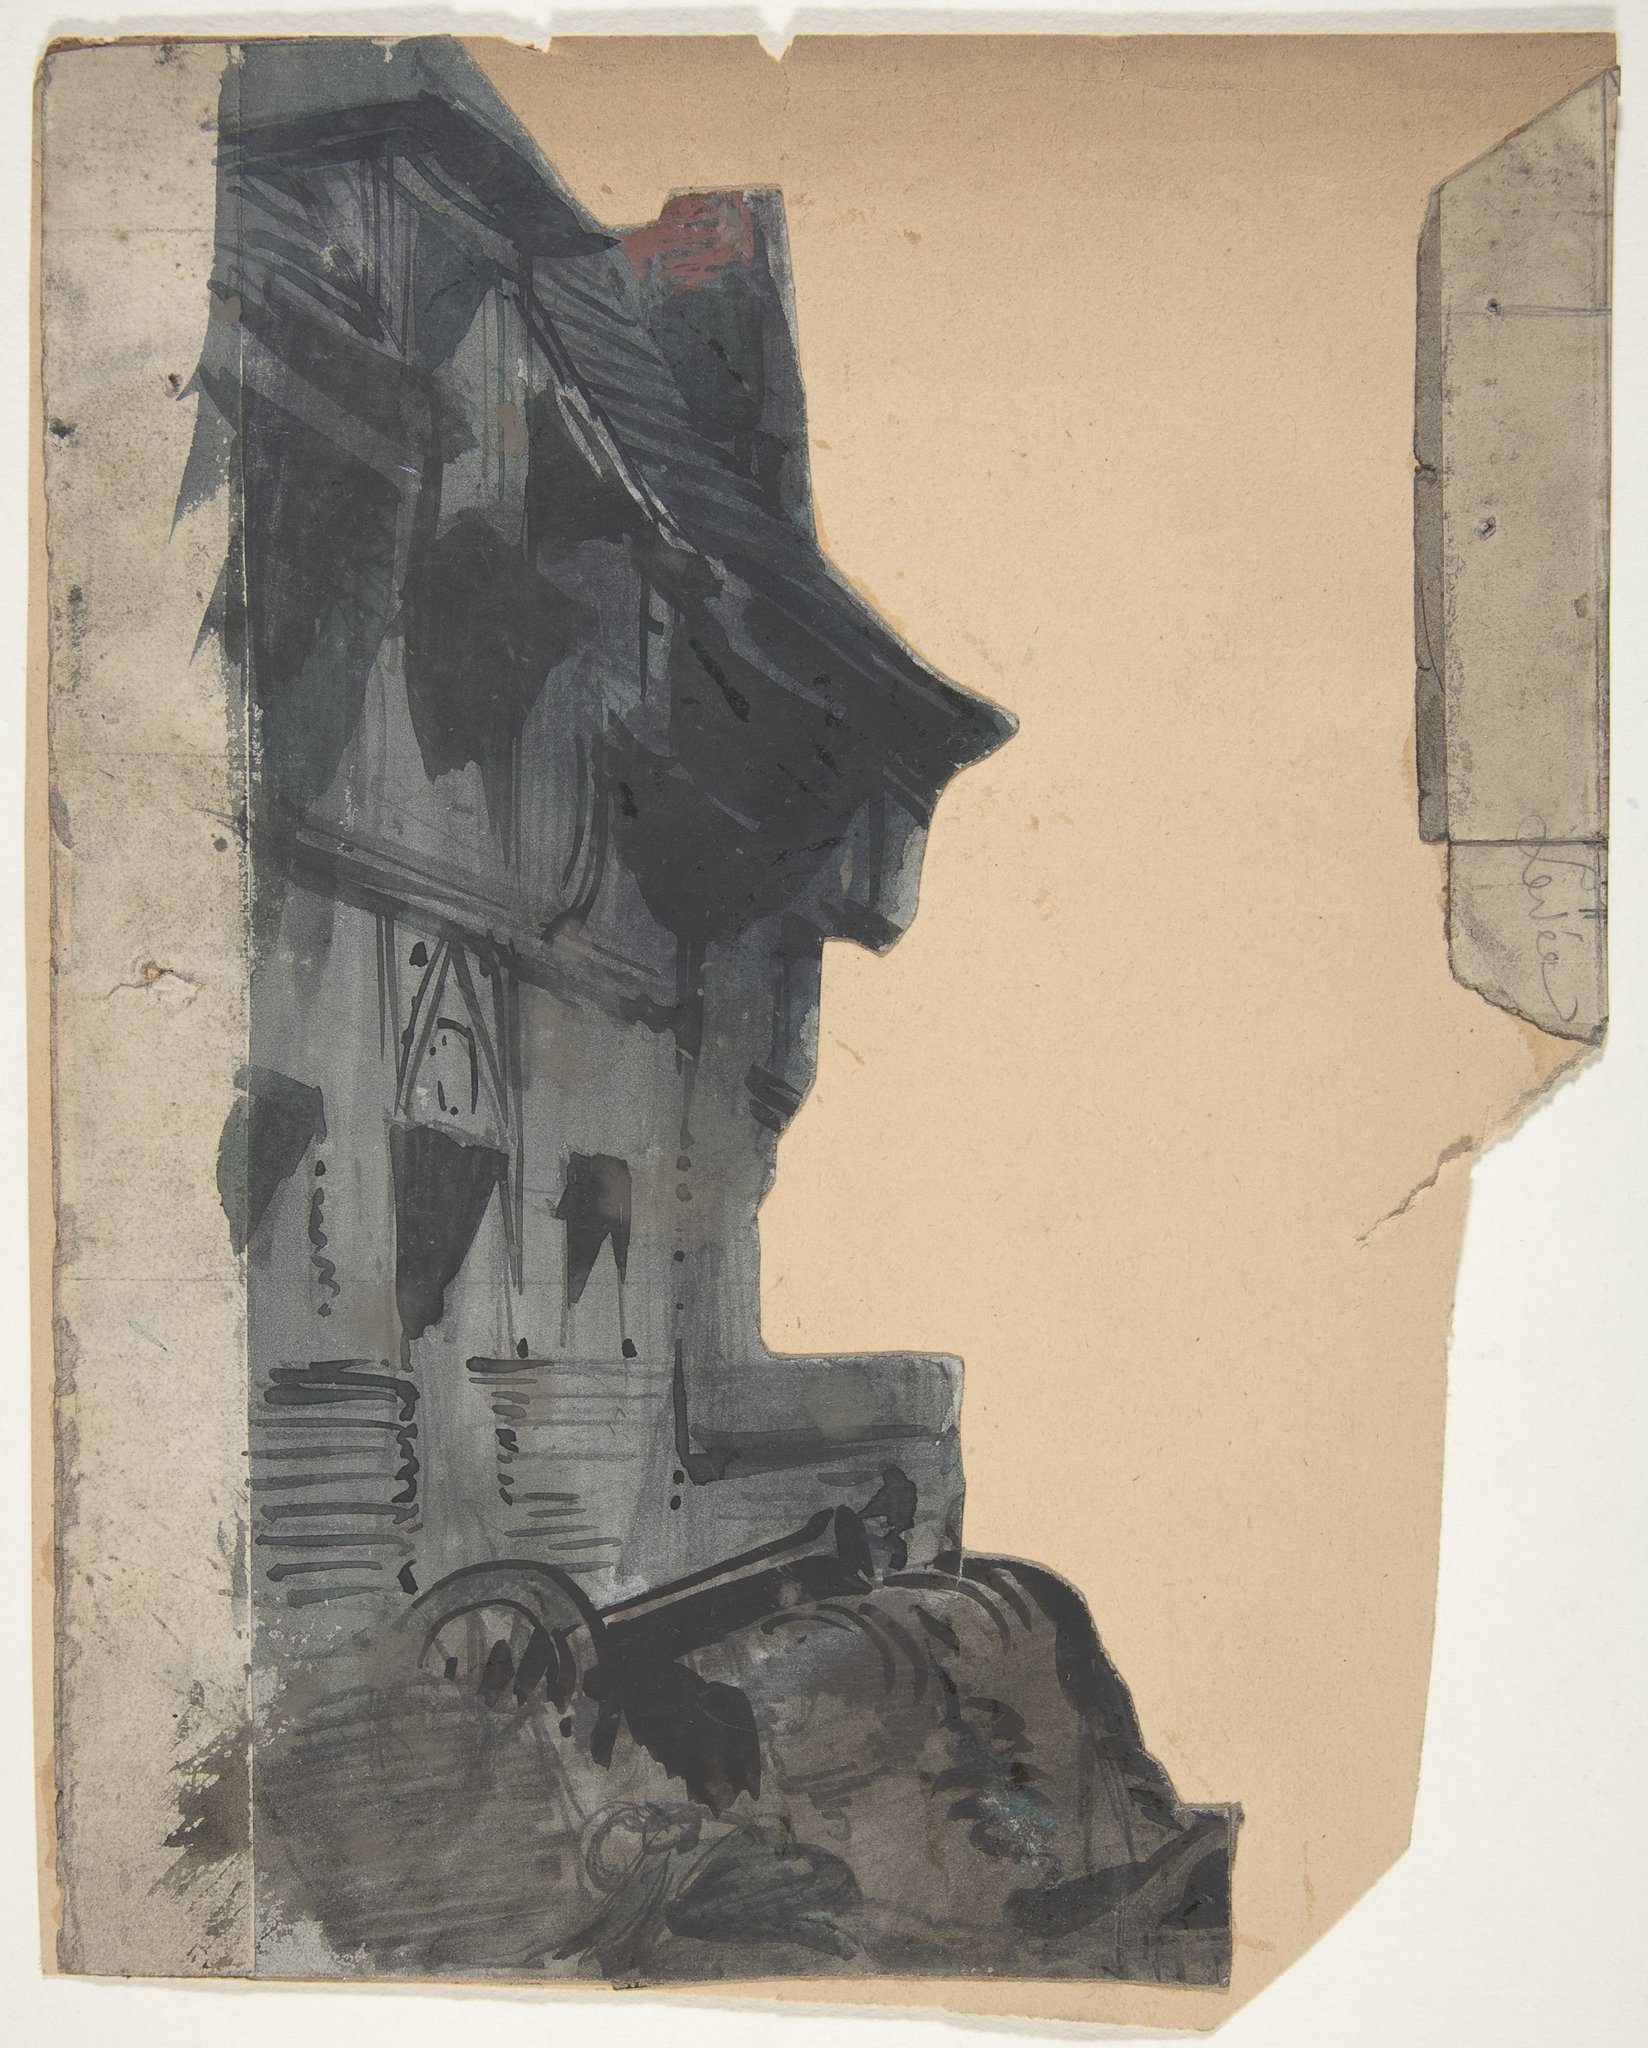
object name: drawing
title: Design for a Stage Set at the Opéra, Paris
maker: eugène cicéri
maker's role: artist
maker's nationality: french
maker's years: 1813-1890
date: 1830-1890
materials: graphite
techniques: brush, wash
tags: cannons,stage design